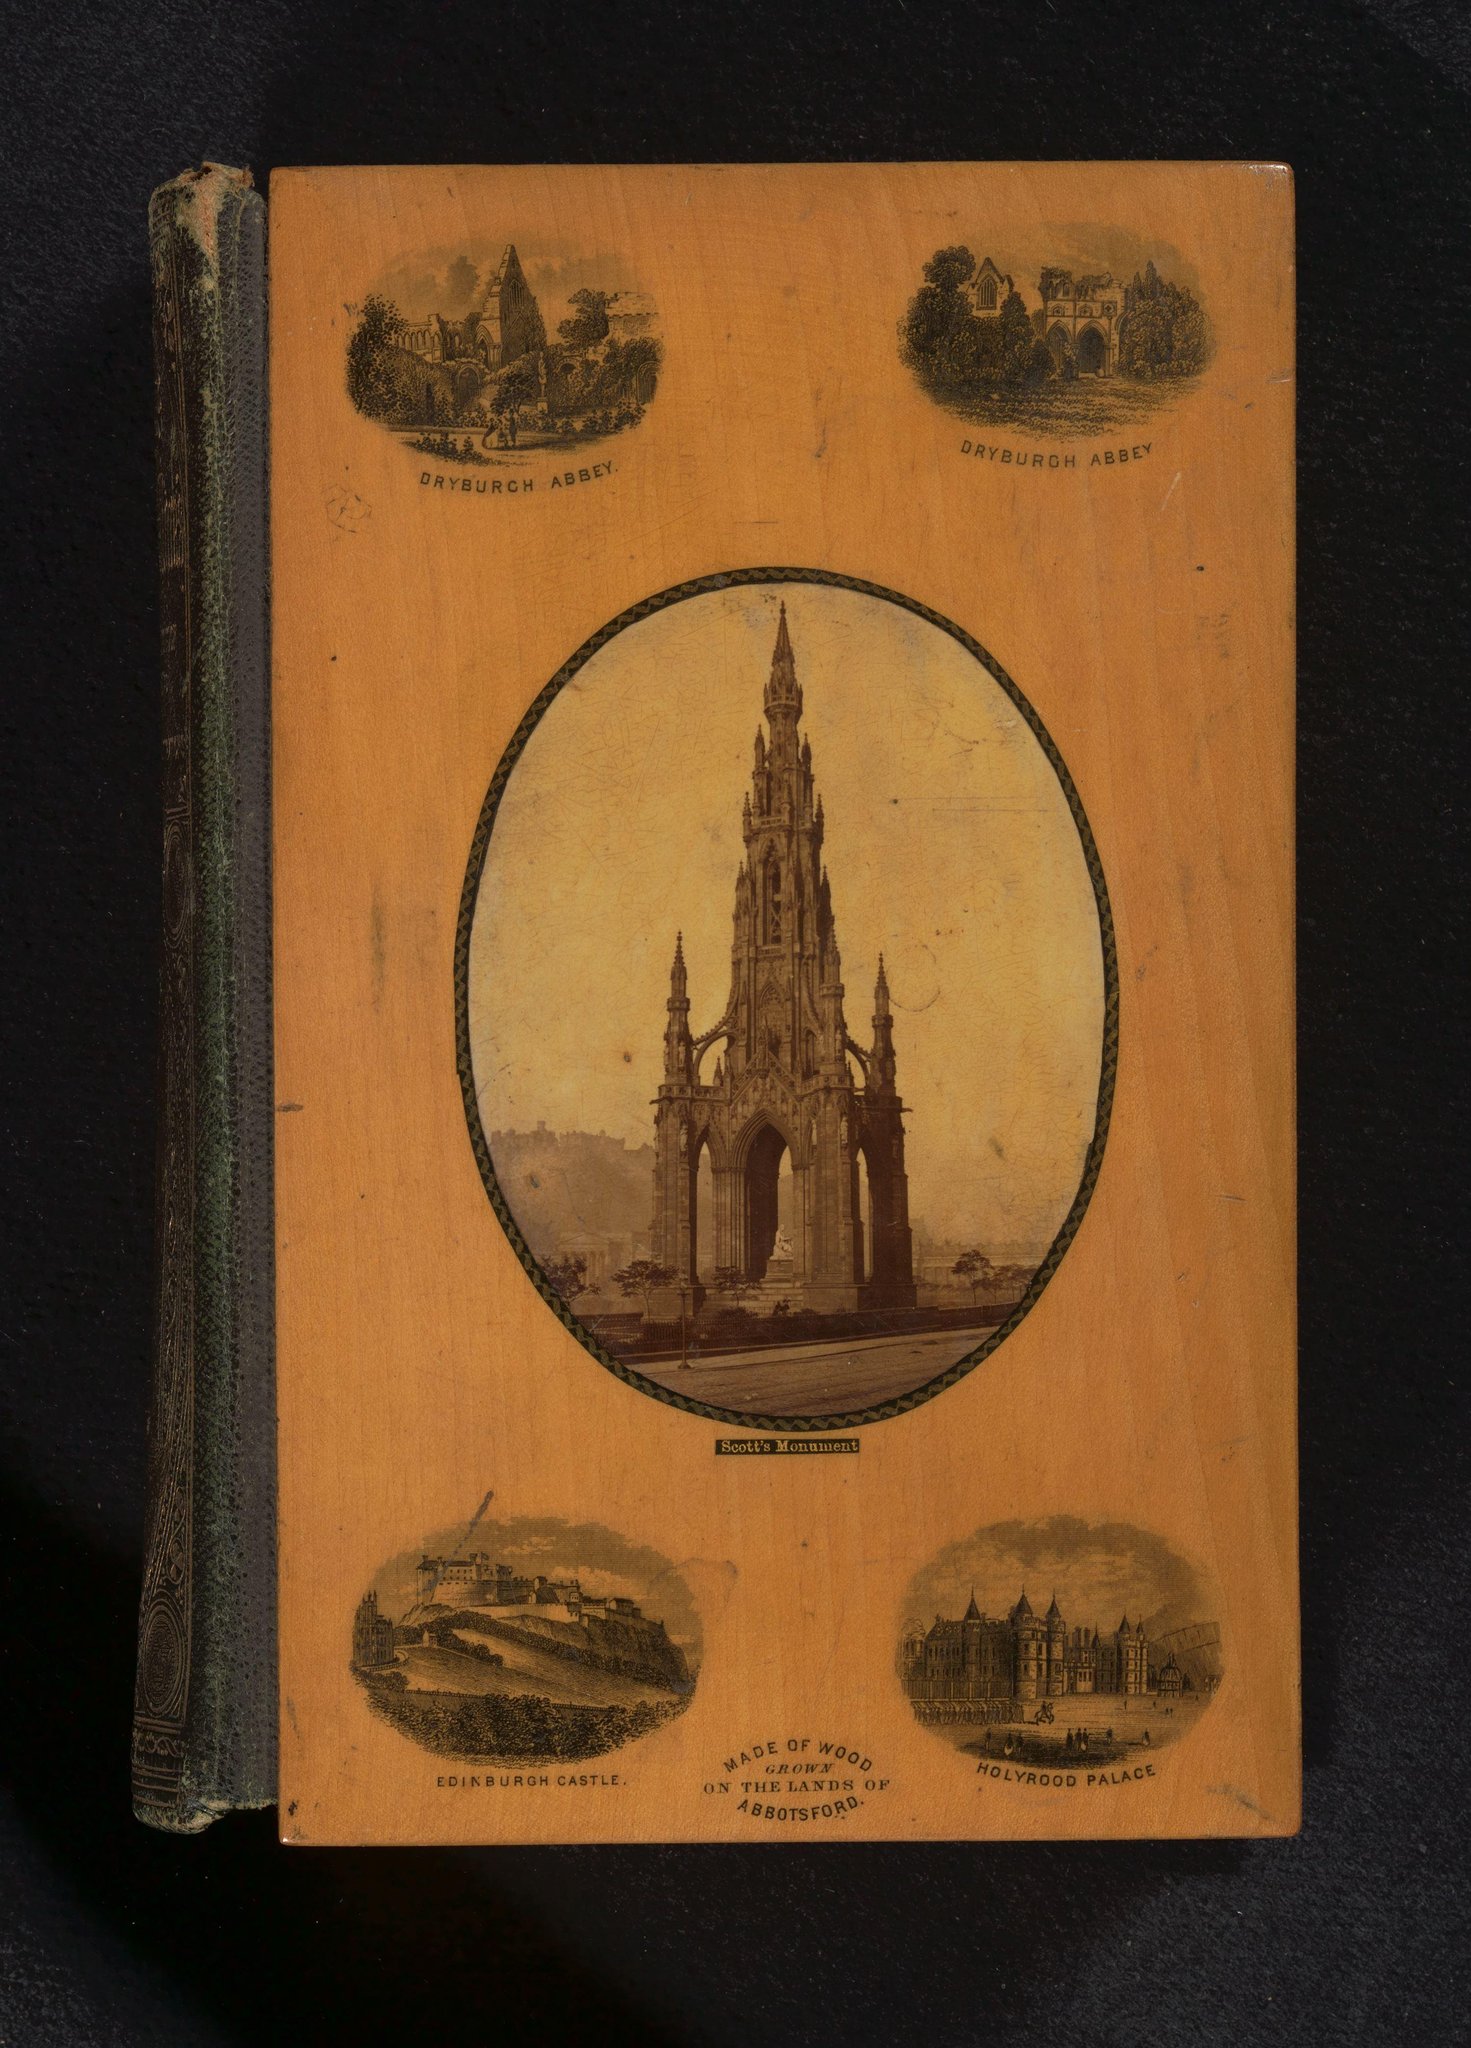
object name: page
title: Scott's Monument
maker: Anonymous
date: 1858-1868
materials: photographic support, wood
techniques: albumen print, printing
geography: edinburgh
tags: monument, statue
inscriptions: inscription: ‘Made of wood grown on the Lands of Abbotsford.’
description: Foto is omringd door 4 drukken, met de klok mee: Dryburch Abbey, Dryburg Abbey, Edinburgh Castle en Holyrood Palace.